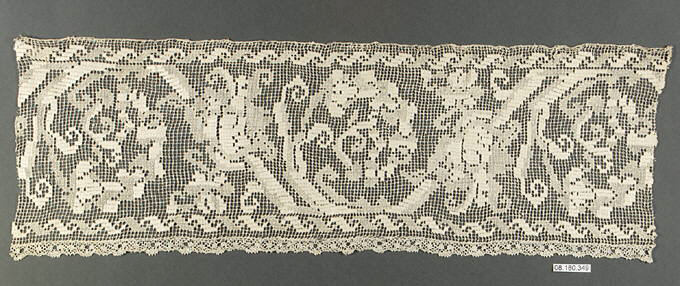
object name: fragment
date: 1801-1900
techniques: embroidery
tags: leaves